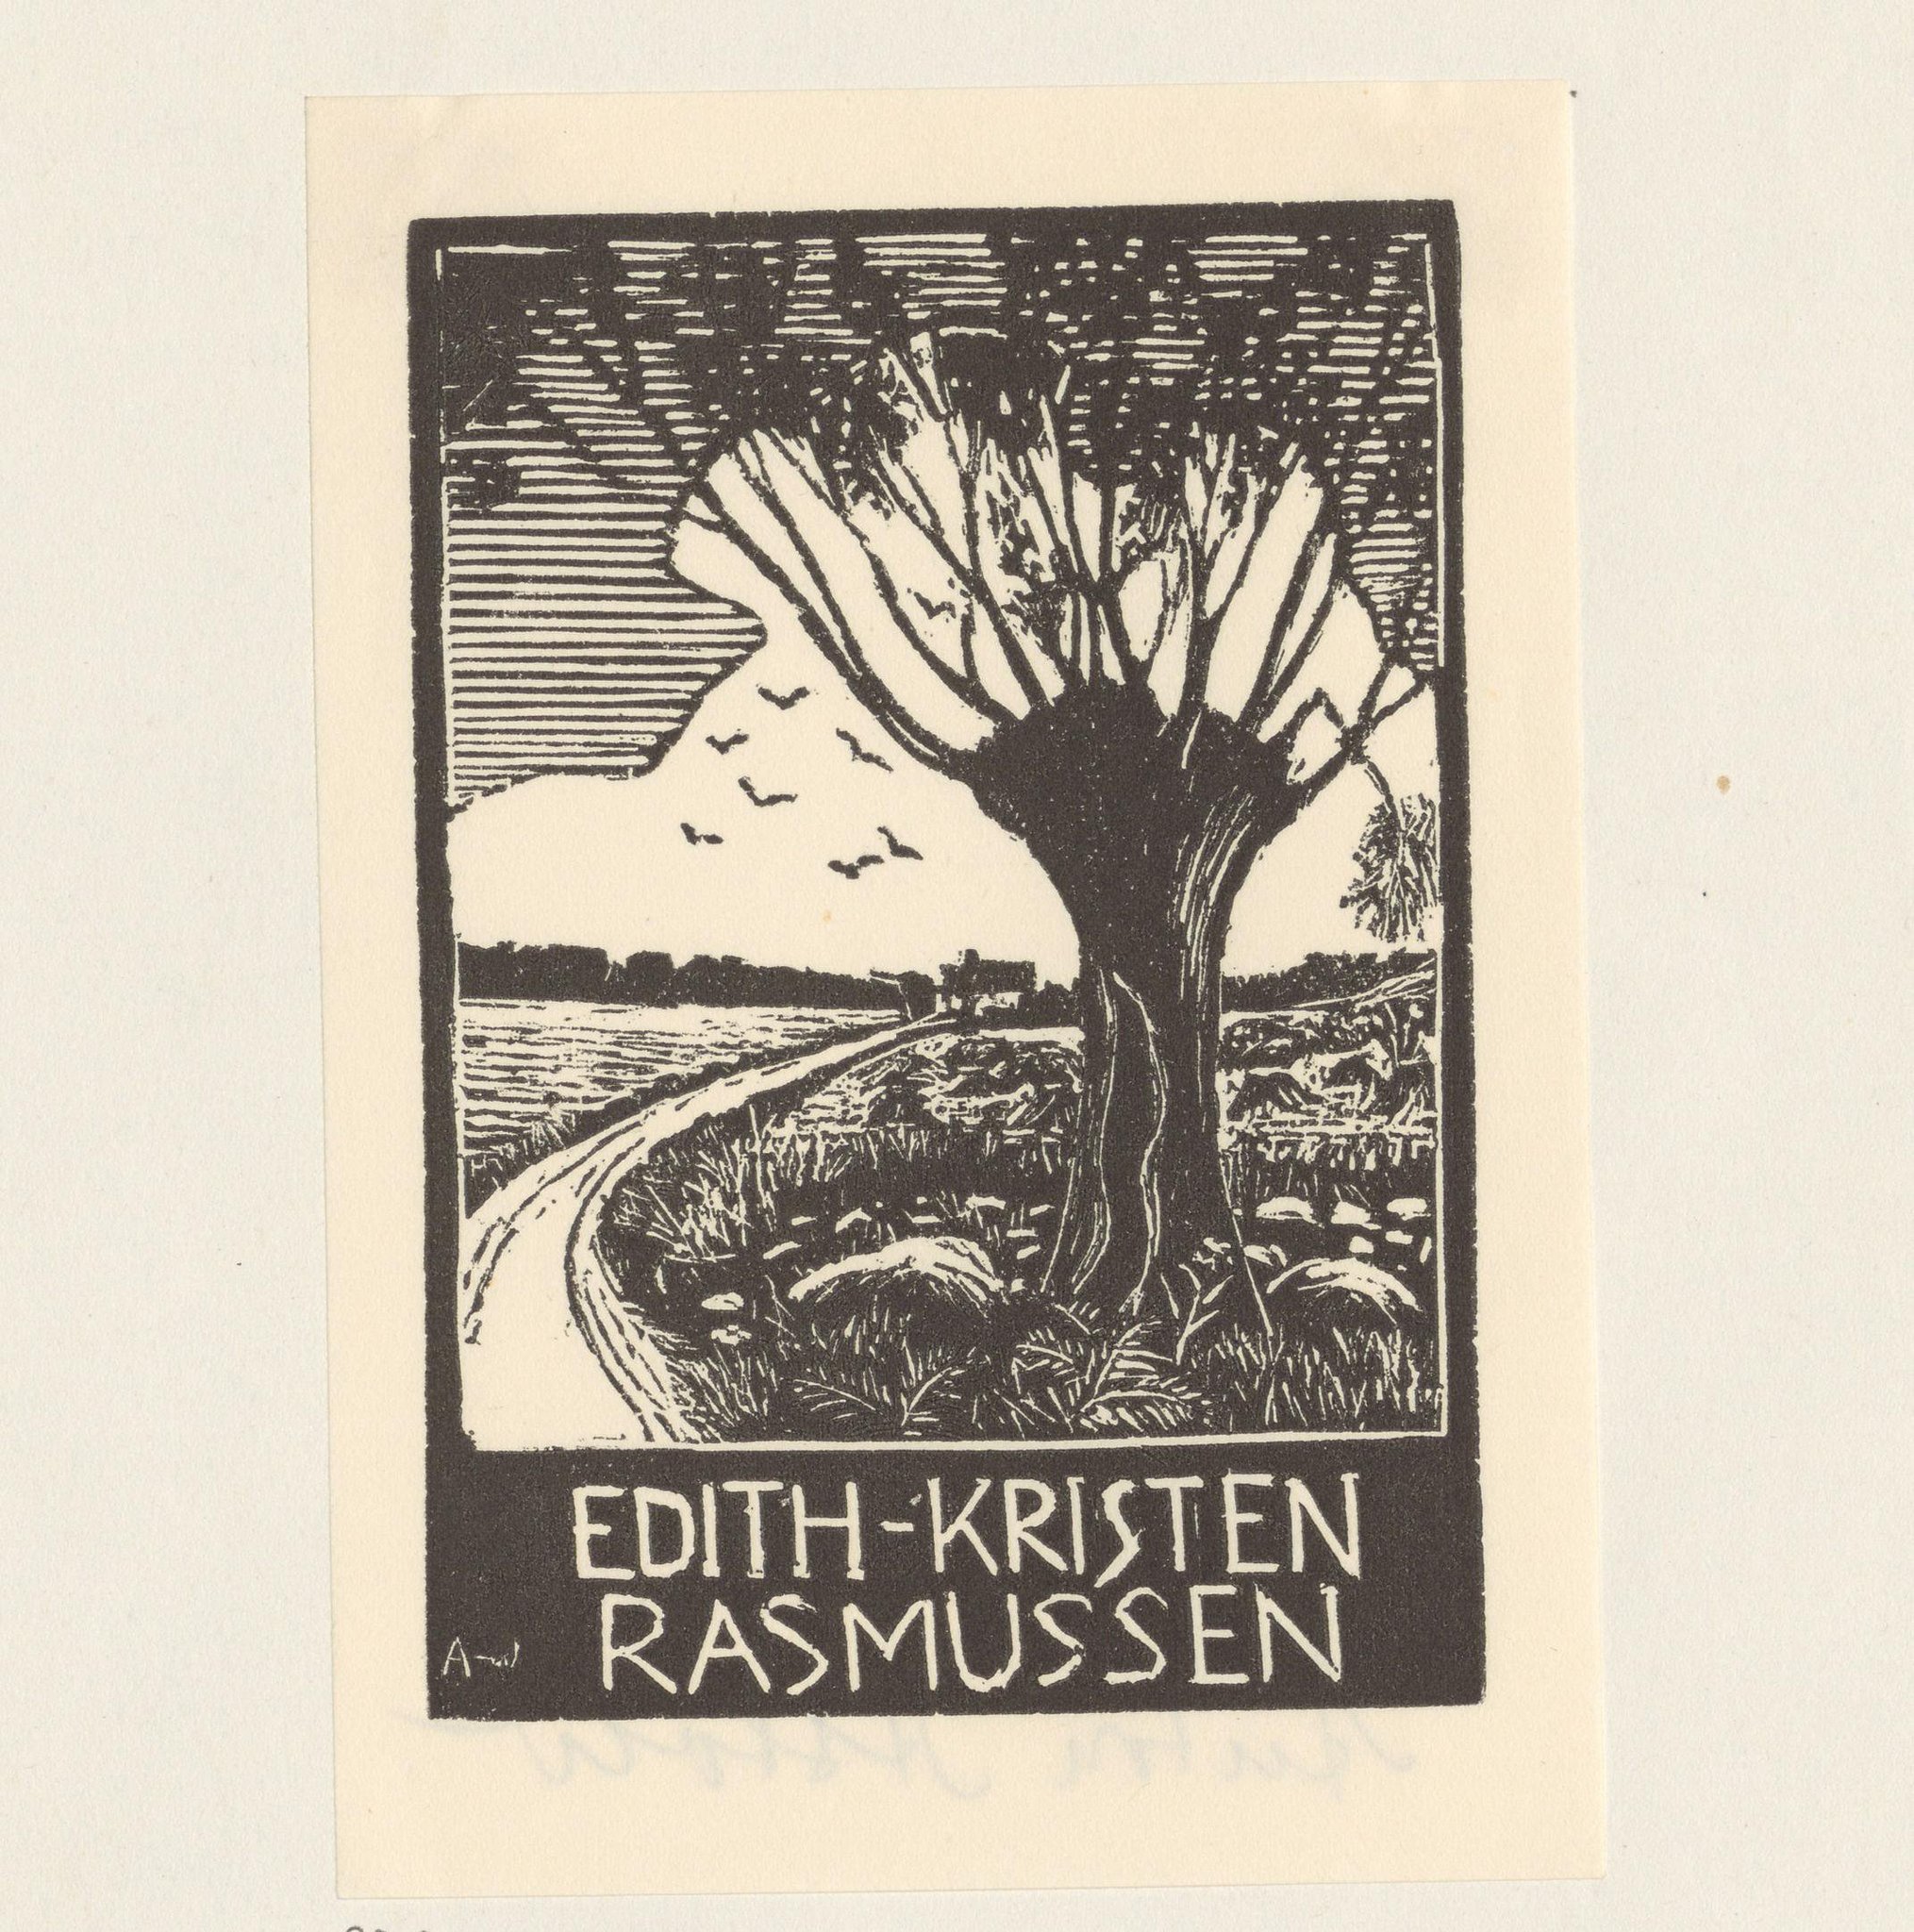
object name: bookplate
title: Ex libris van Edith-Kristen Rasmussen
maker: Anonymous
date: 1900-1999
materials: paper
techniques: linocut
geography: sweden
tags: birds, meadow, pasture, trees: willow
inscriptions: inscription: ‘Anton Aslow (?)’